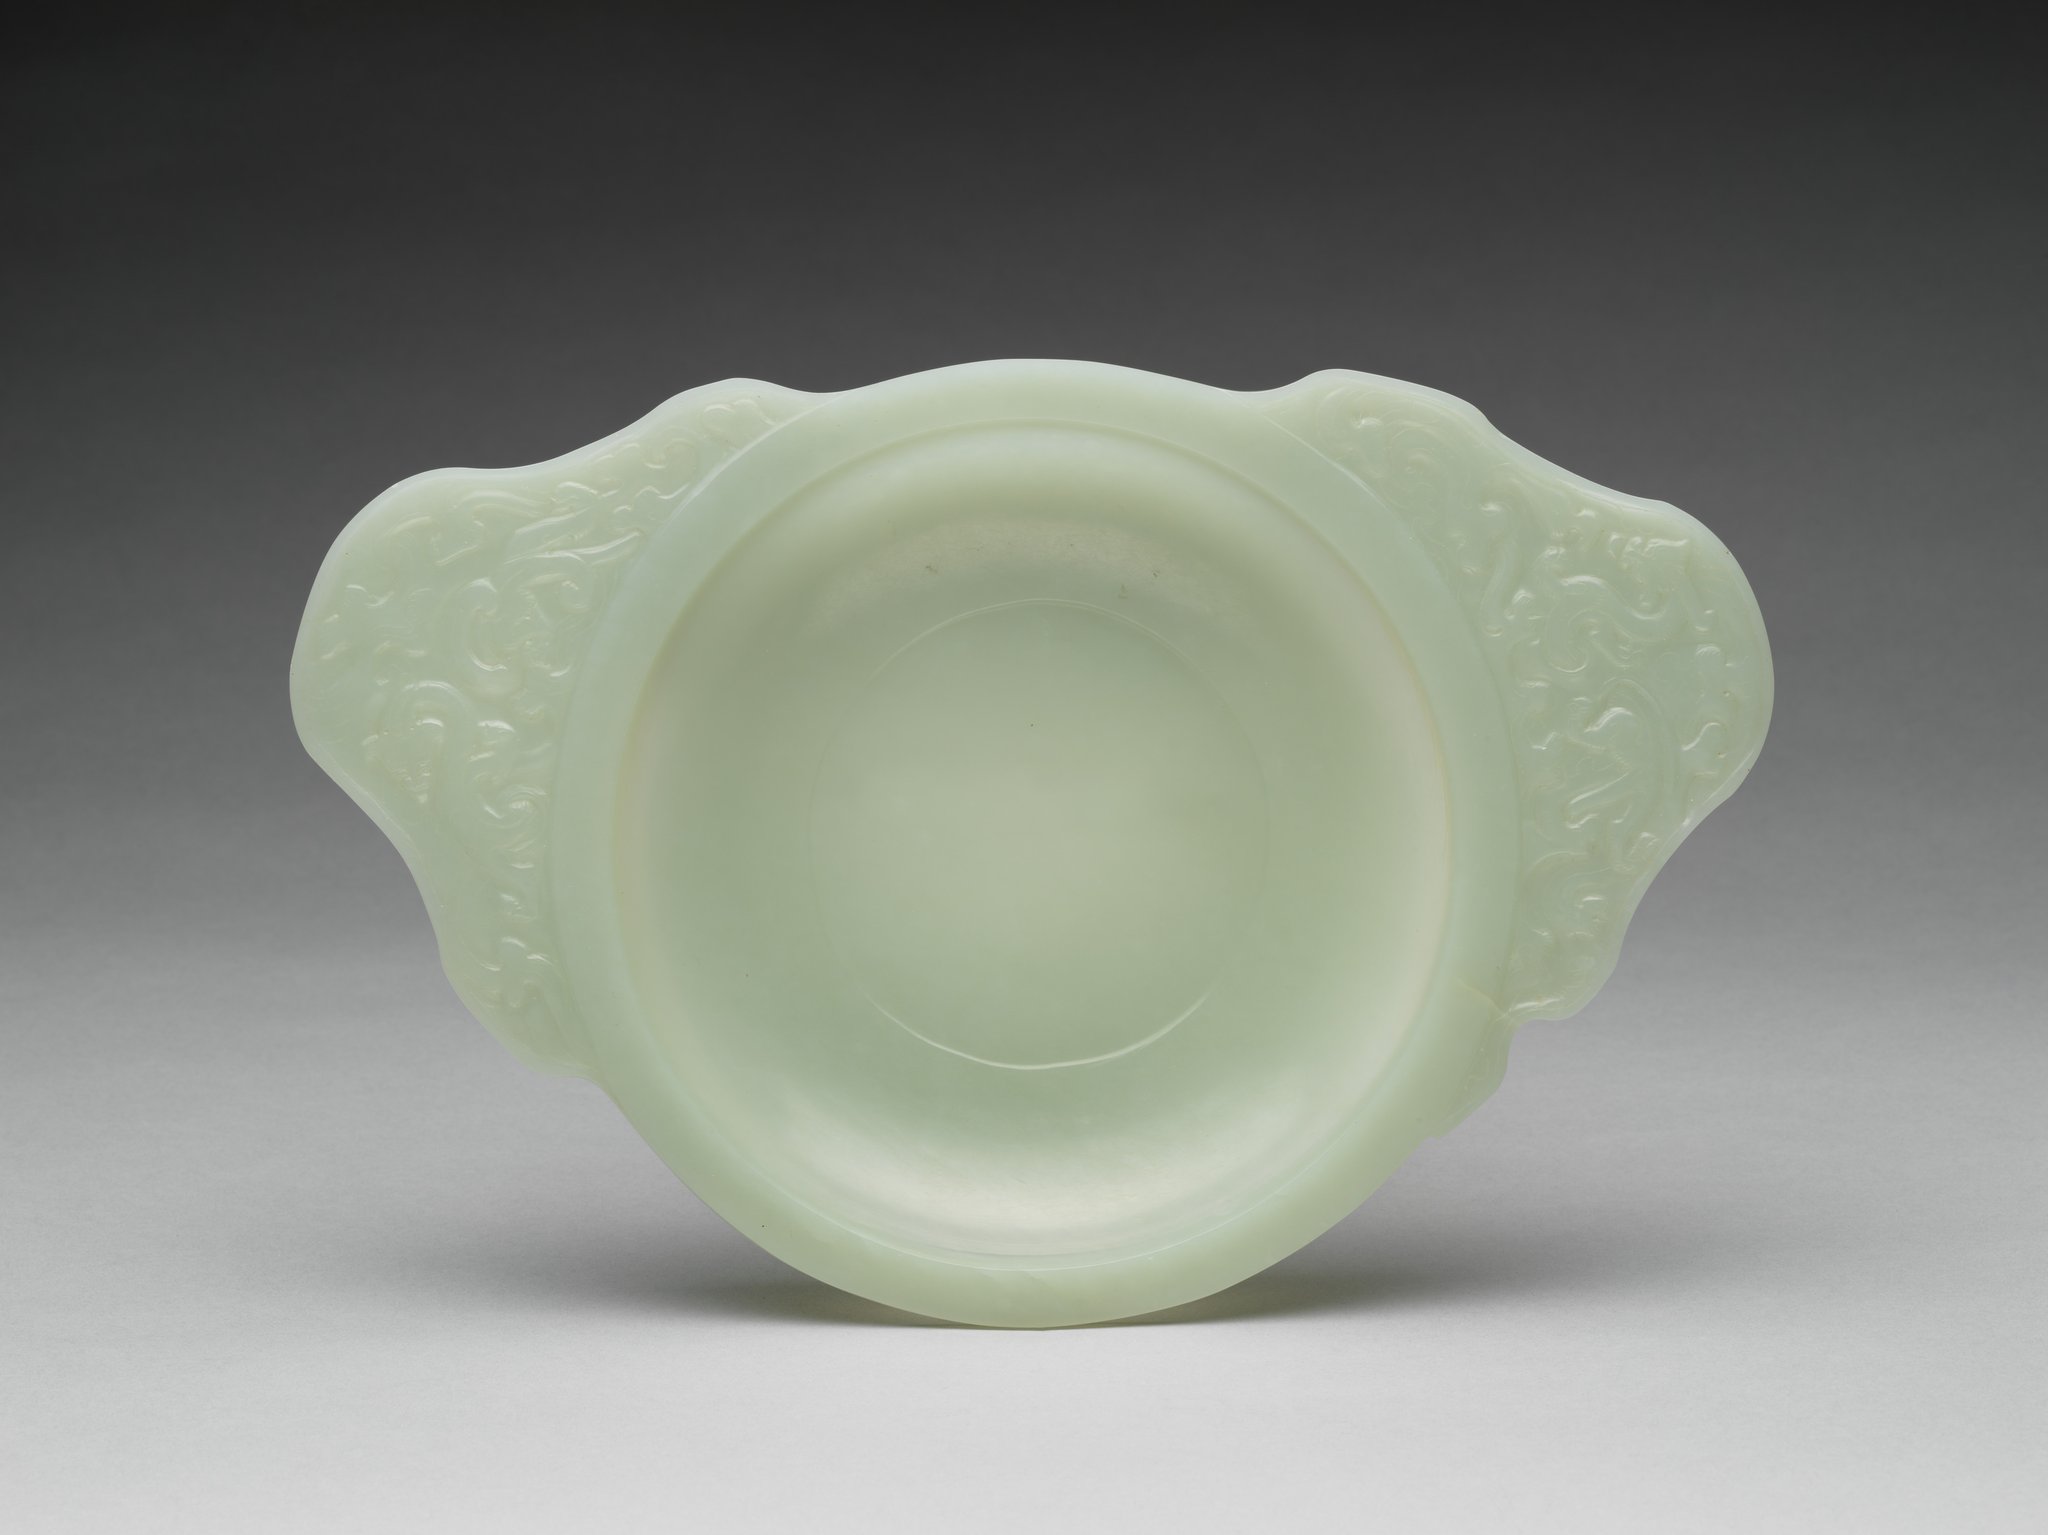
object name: dish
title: Dish with dragon handles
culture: chinese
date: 1301-1400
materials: jade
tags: dragons